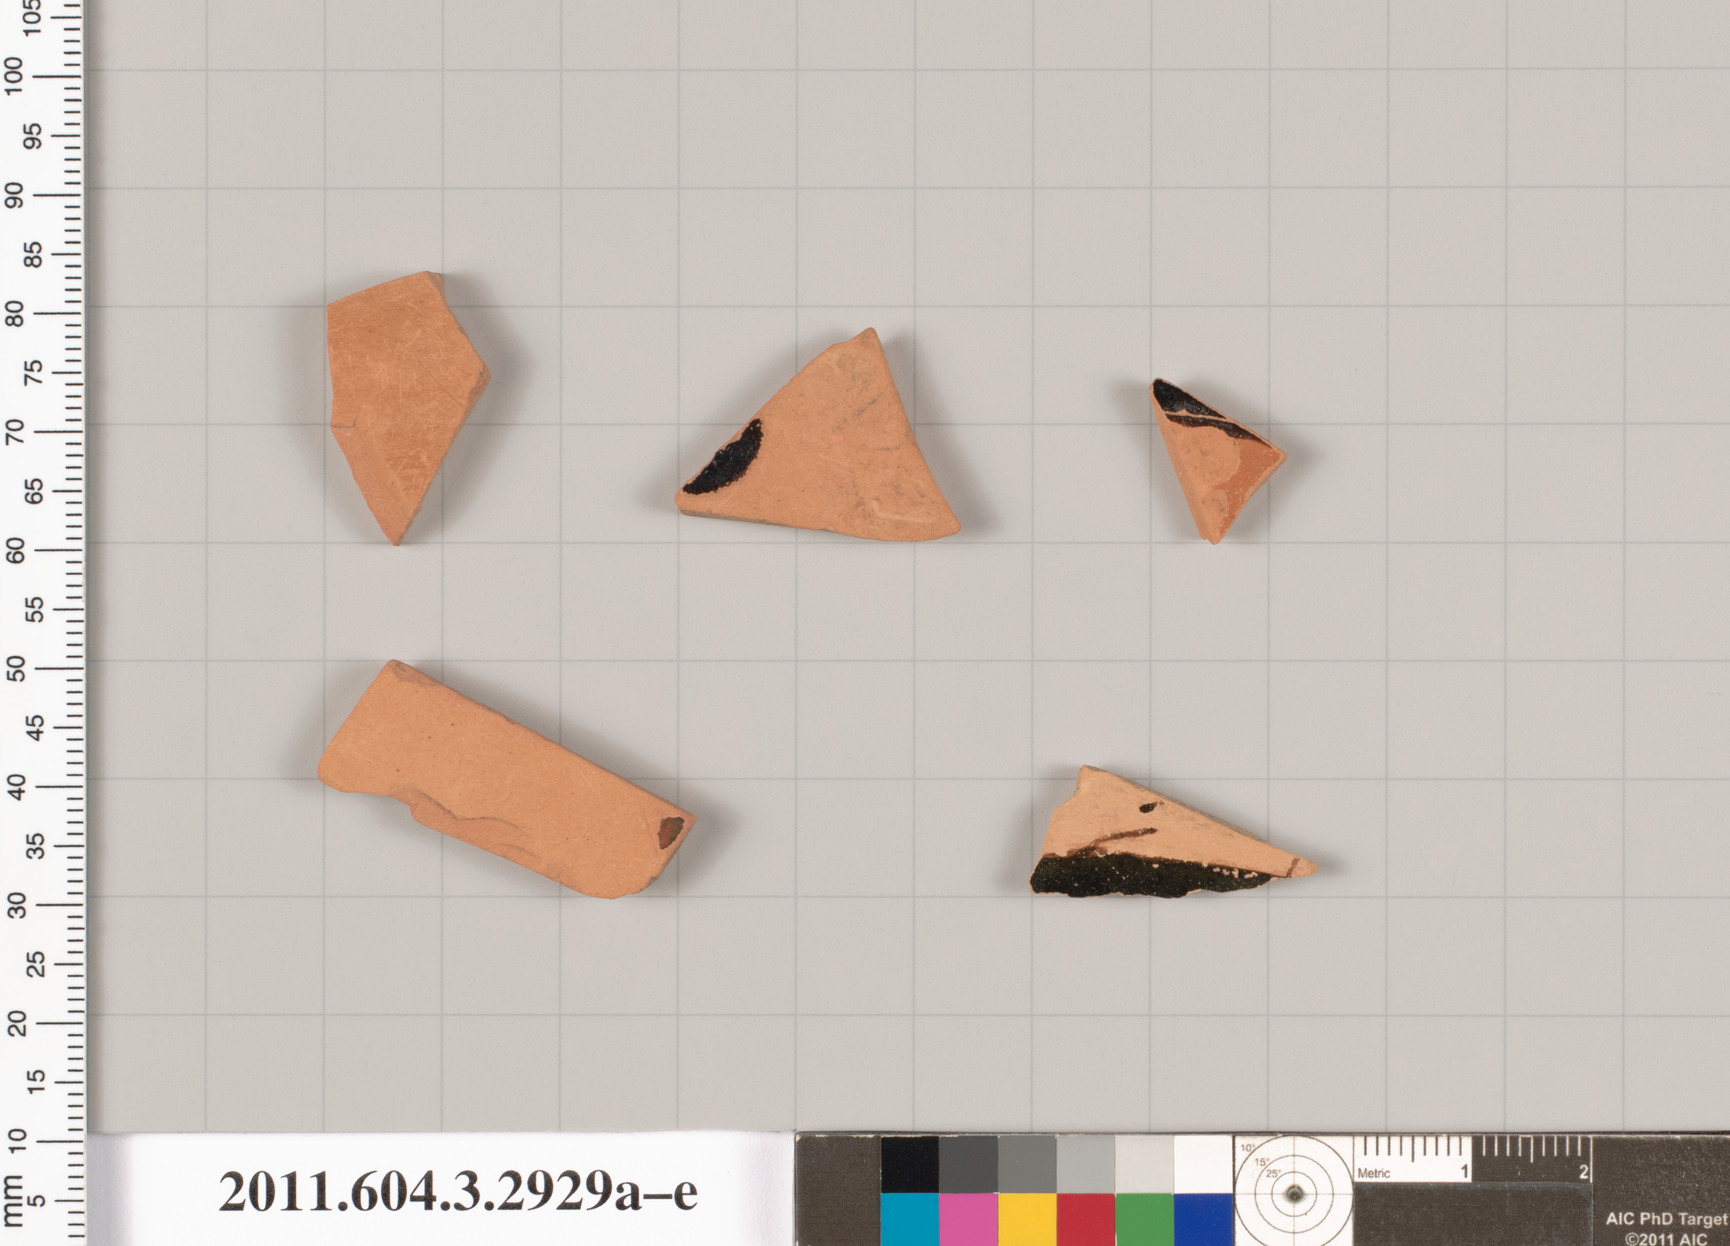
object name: undetermined closed shape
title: Terracotta fragments of closed shapes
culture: greek, attic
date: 575-540 BCE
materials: terracotta